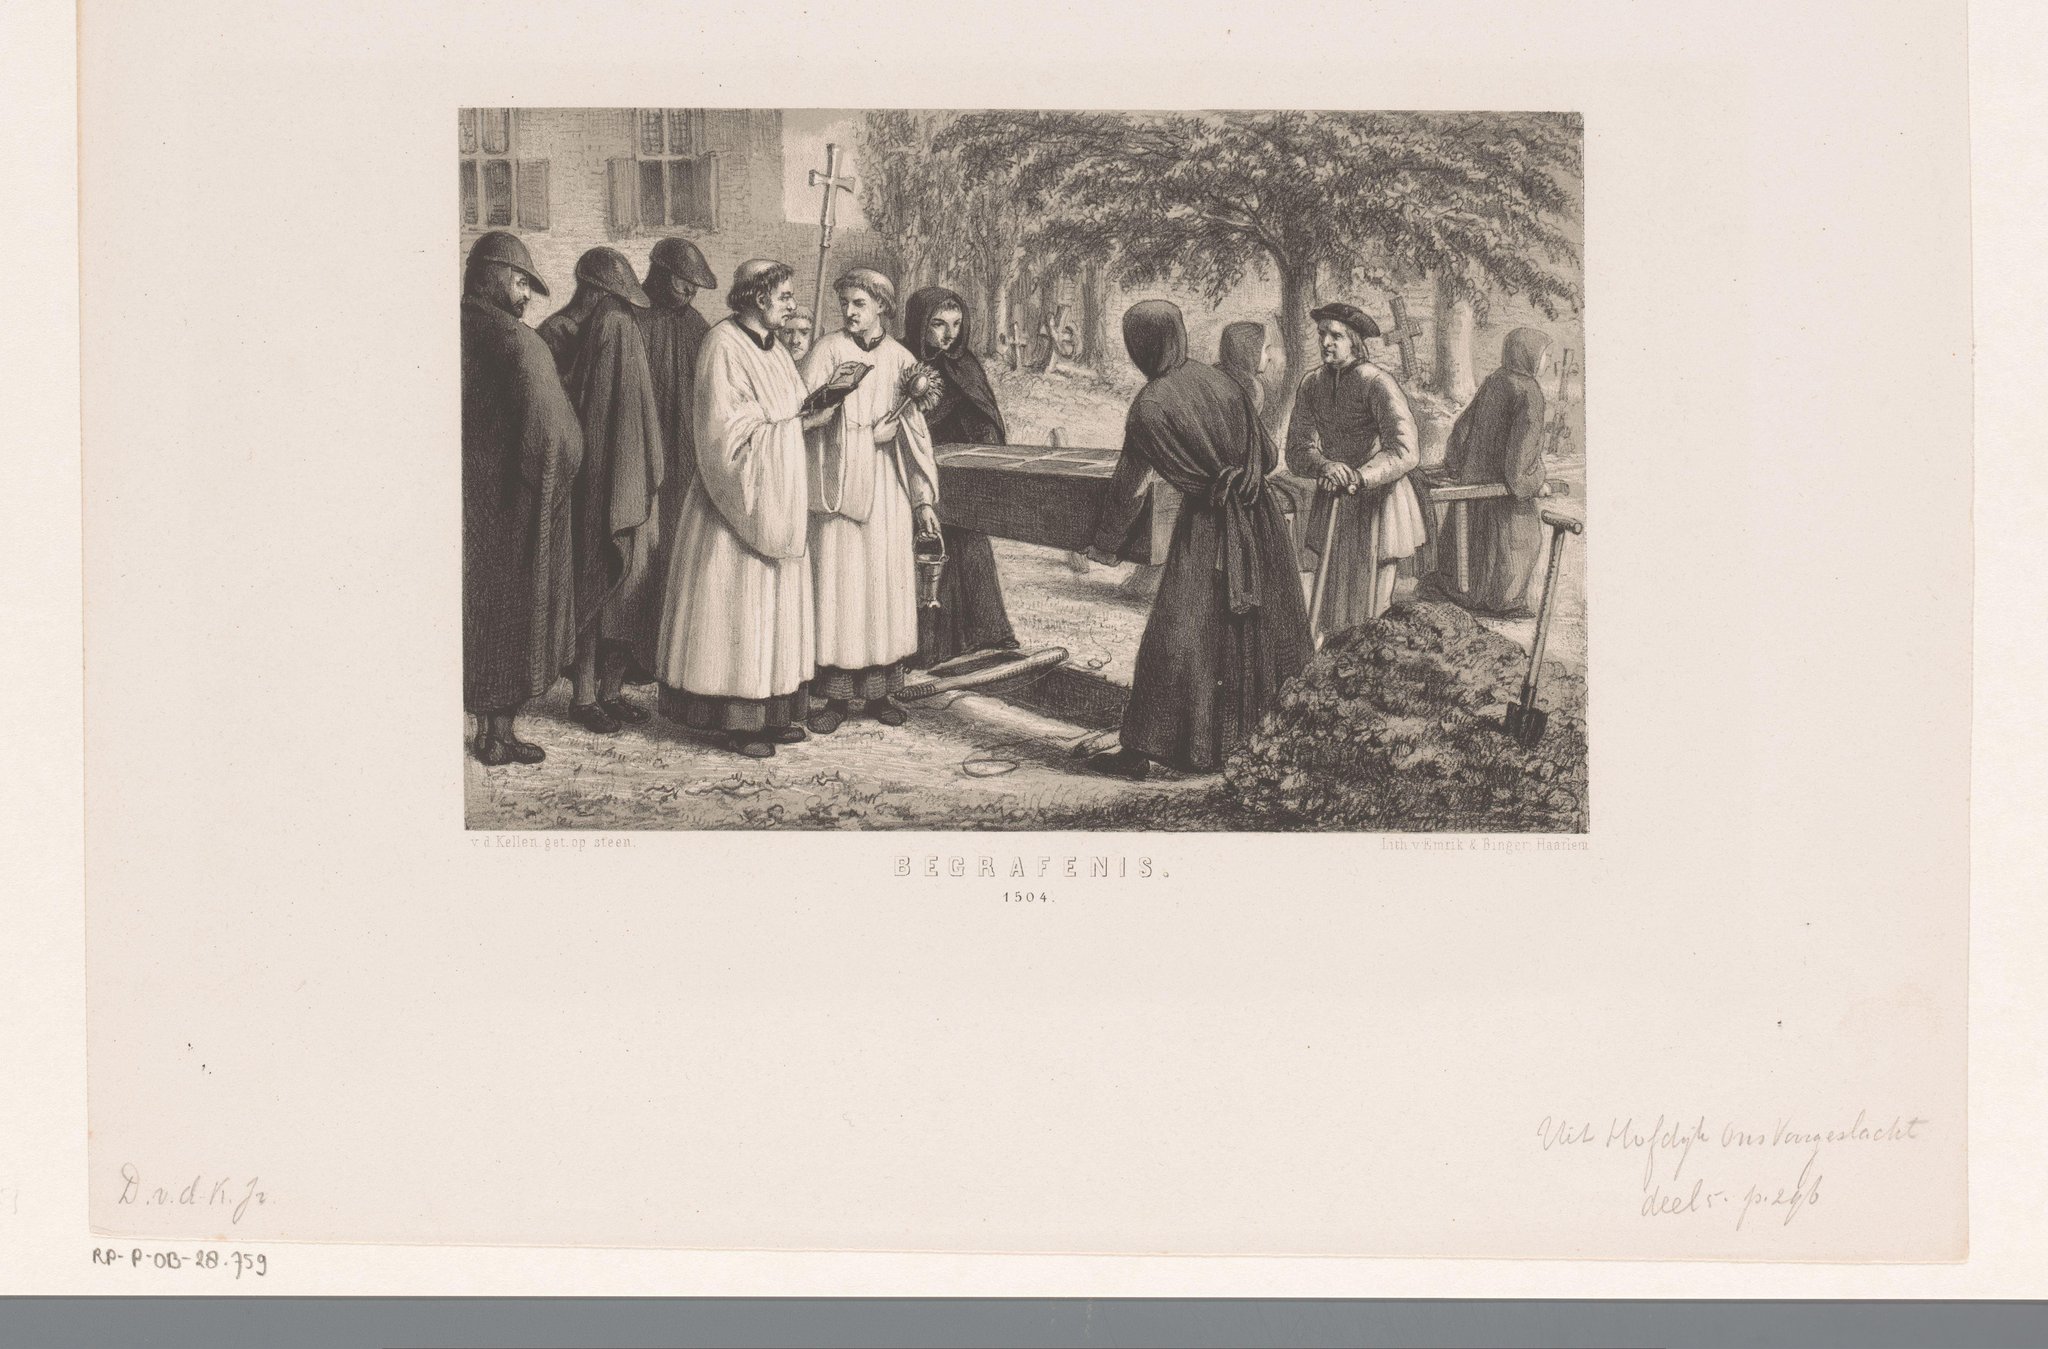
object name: print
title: Begrafenis 1504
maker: david van der kellen (1827-1895)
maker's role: draughtsman, print maker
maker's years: 1827-1895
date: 1859-1864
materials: paper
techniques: tone lithography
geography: haarlem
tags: holy water, coffin, funerary ceremonial, mourning the dead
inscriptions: collector's mark: Lugt 2228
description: De priester leest voor uit de Bijbel. Naast hem staat een misdienaar met een borstel en wijwater. De kist wordt door twee figuren in het graf geplaatst. Links drie rouwende figuren.